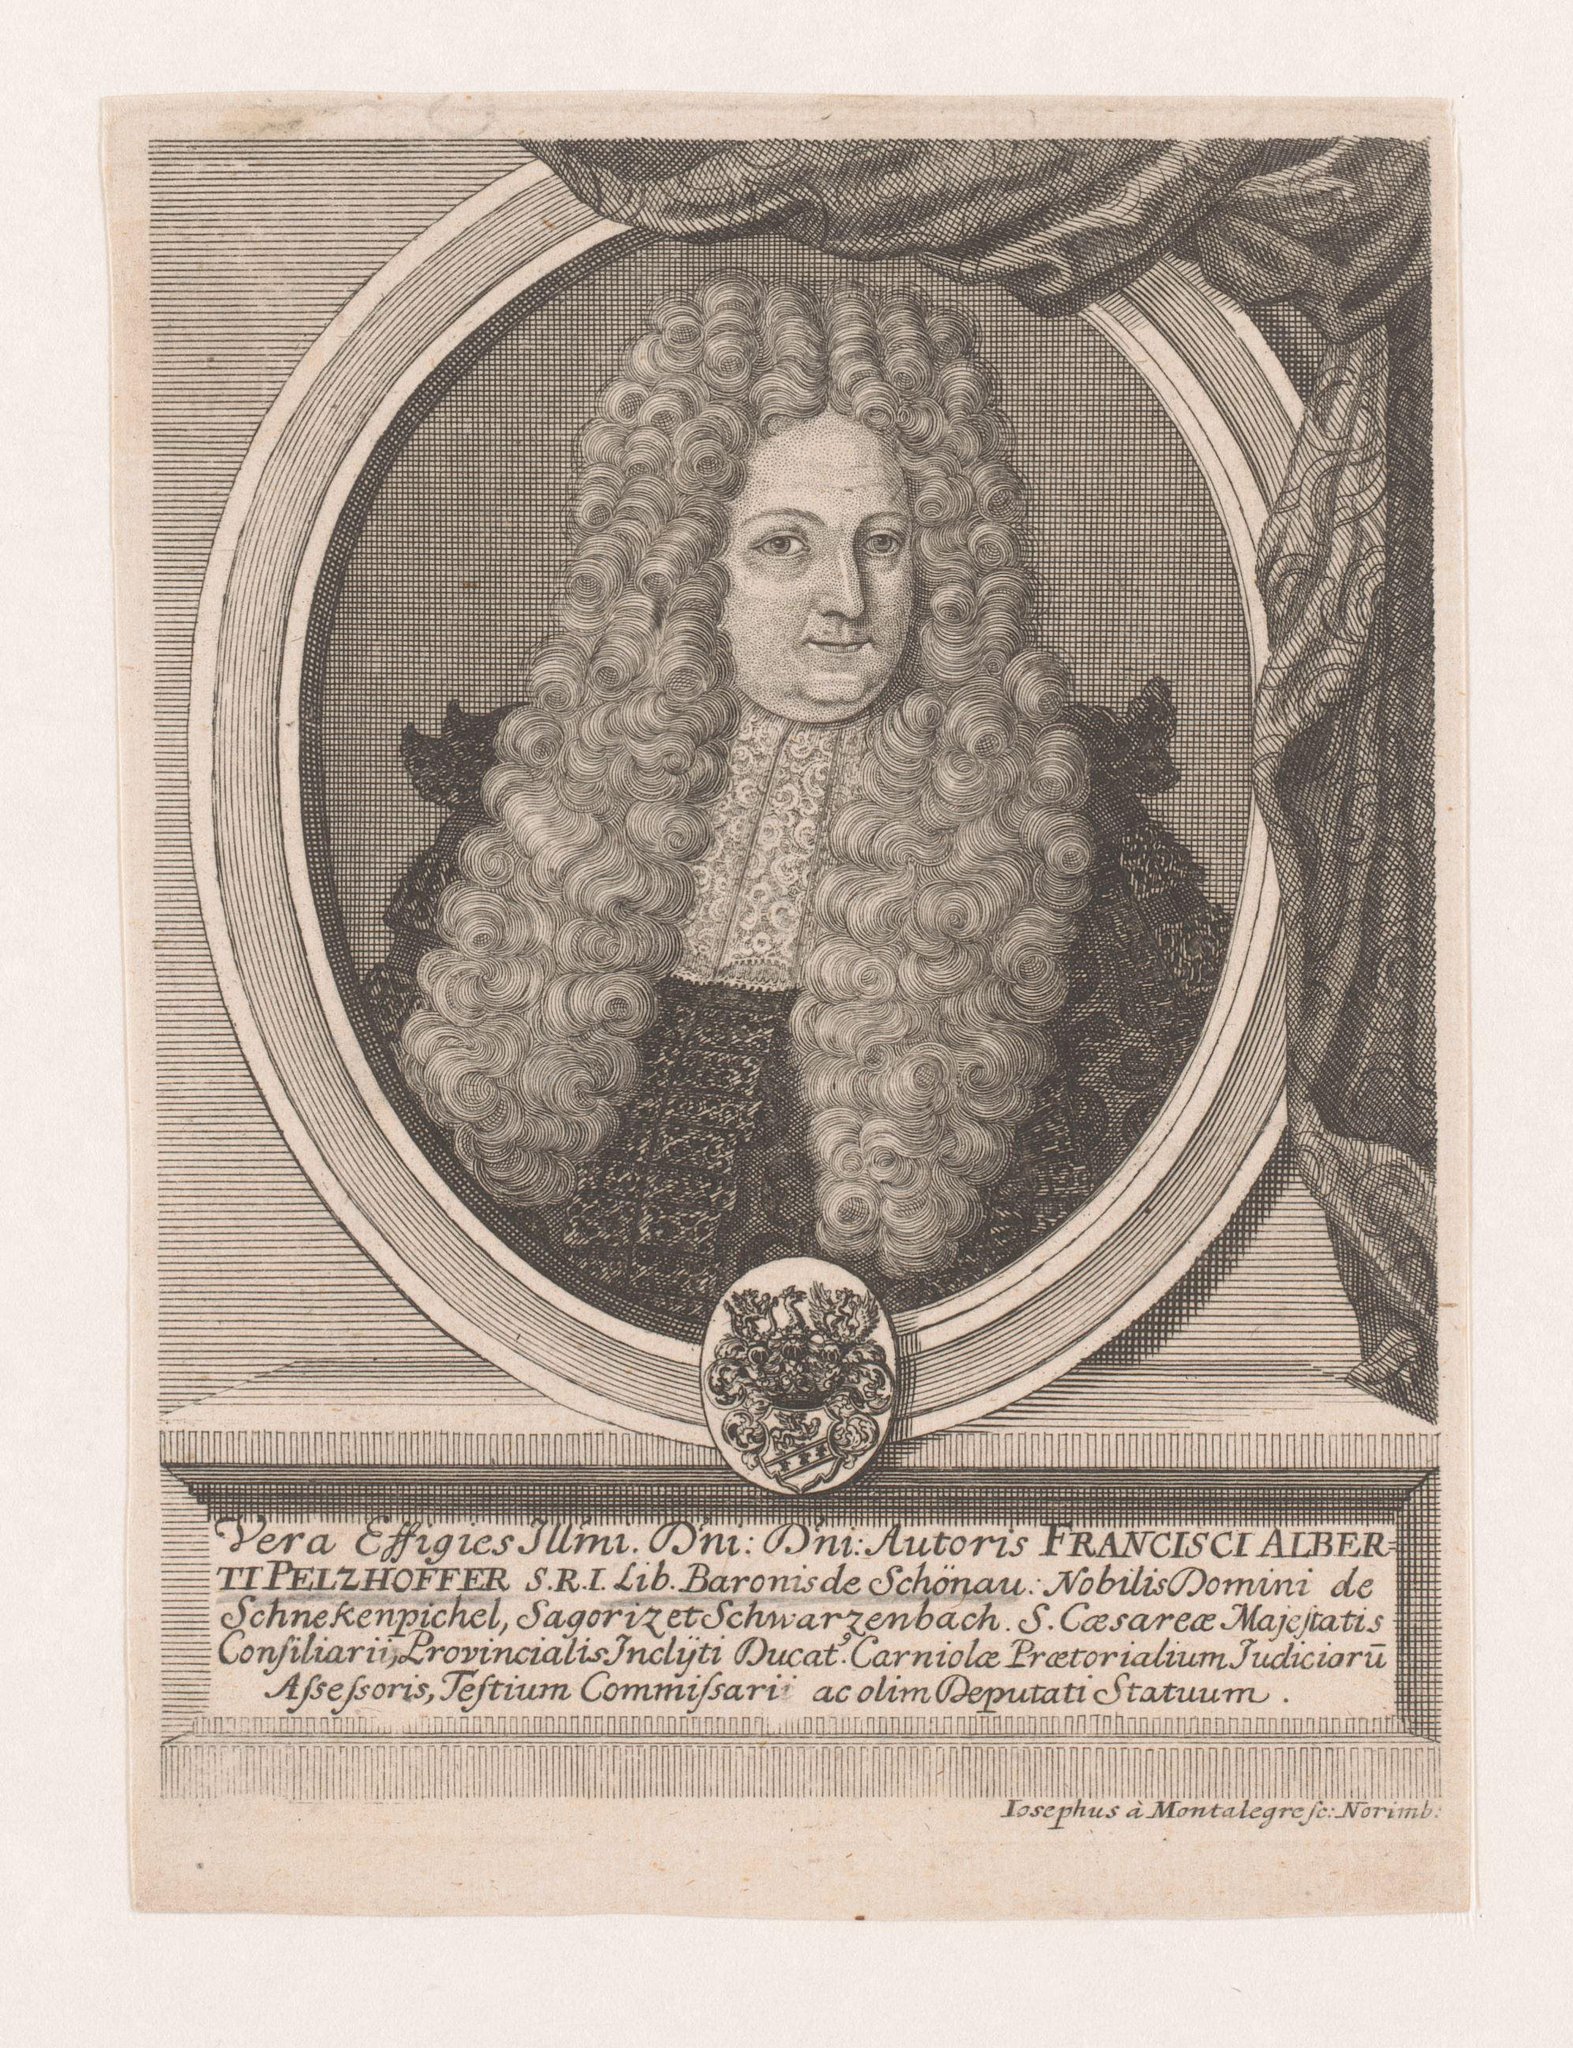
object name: print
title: Portret van Franz Albrecht Pelzhofer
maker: joseph de montalegre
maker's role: print maker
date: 1700-1799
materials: paper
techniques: engraving, etching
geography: nuremberg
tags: historical persons, armorial bearing, heraldry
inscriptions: collector's mark: Lugt 2228